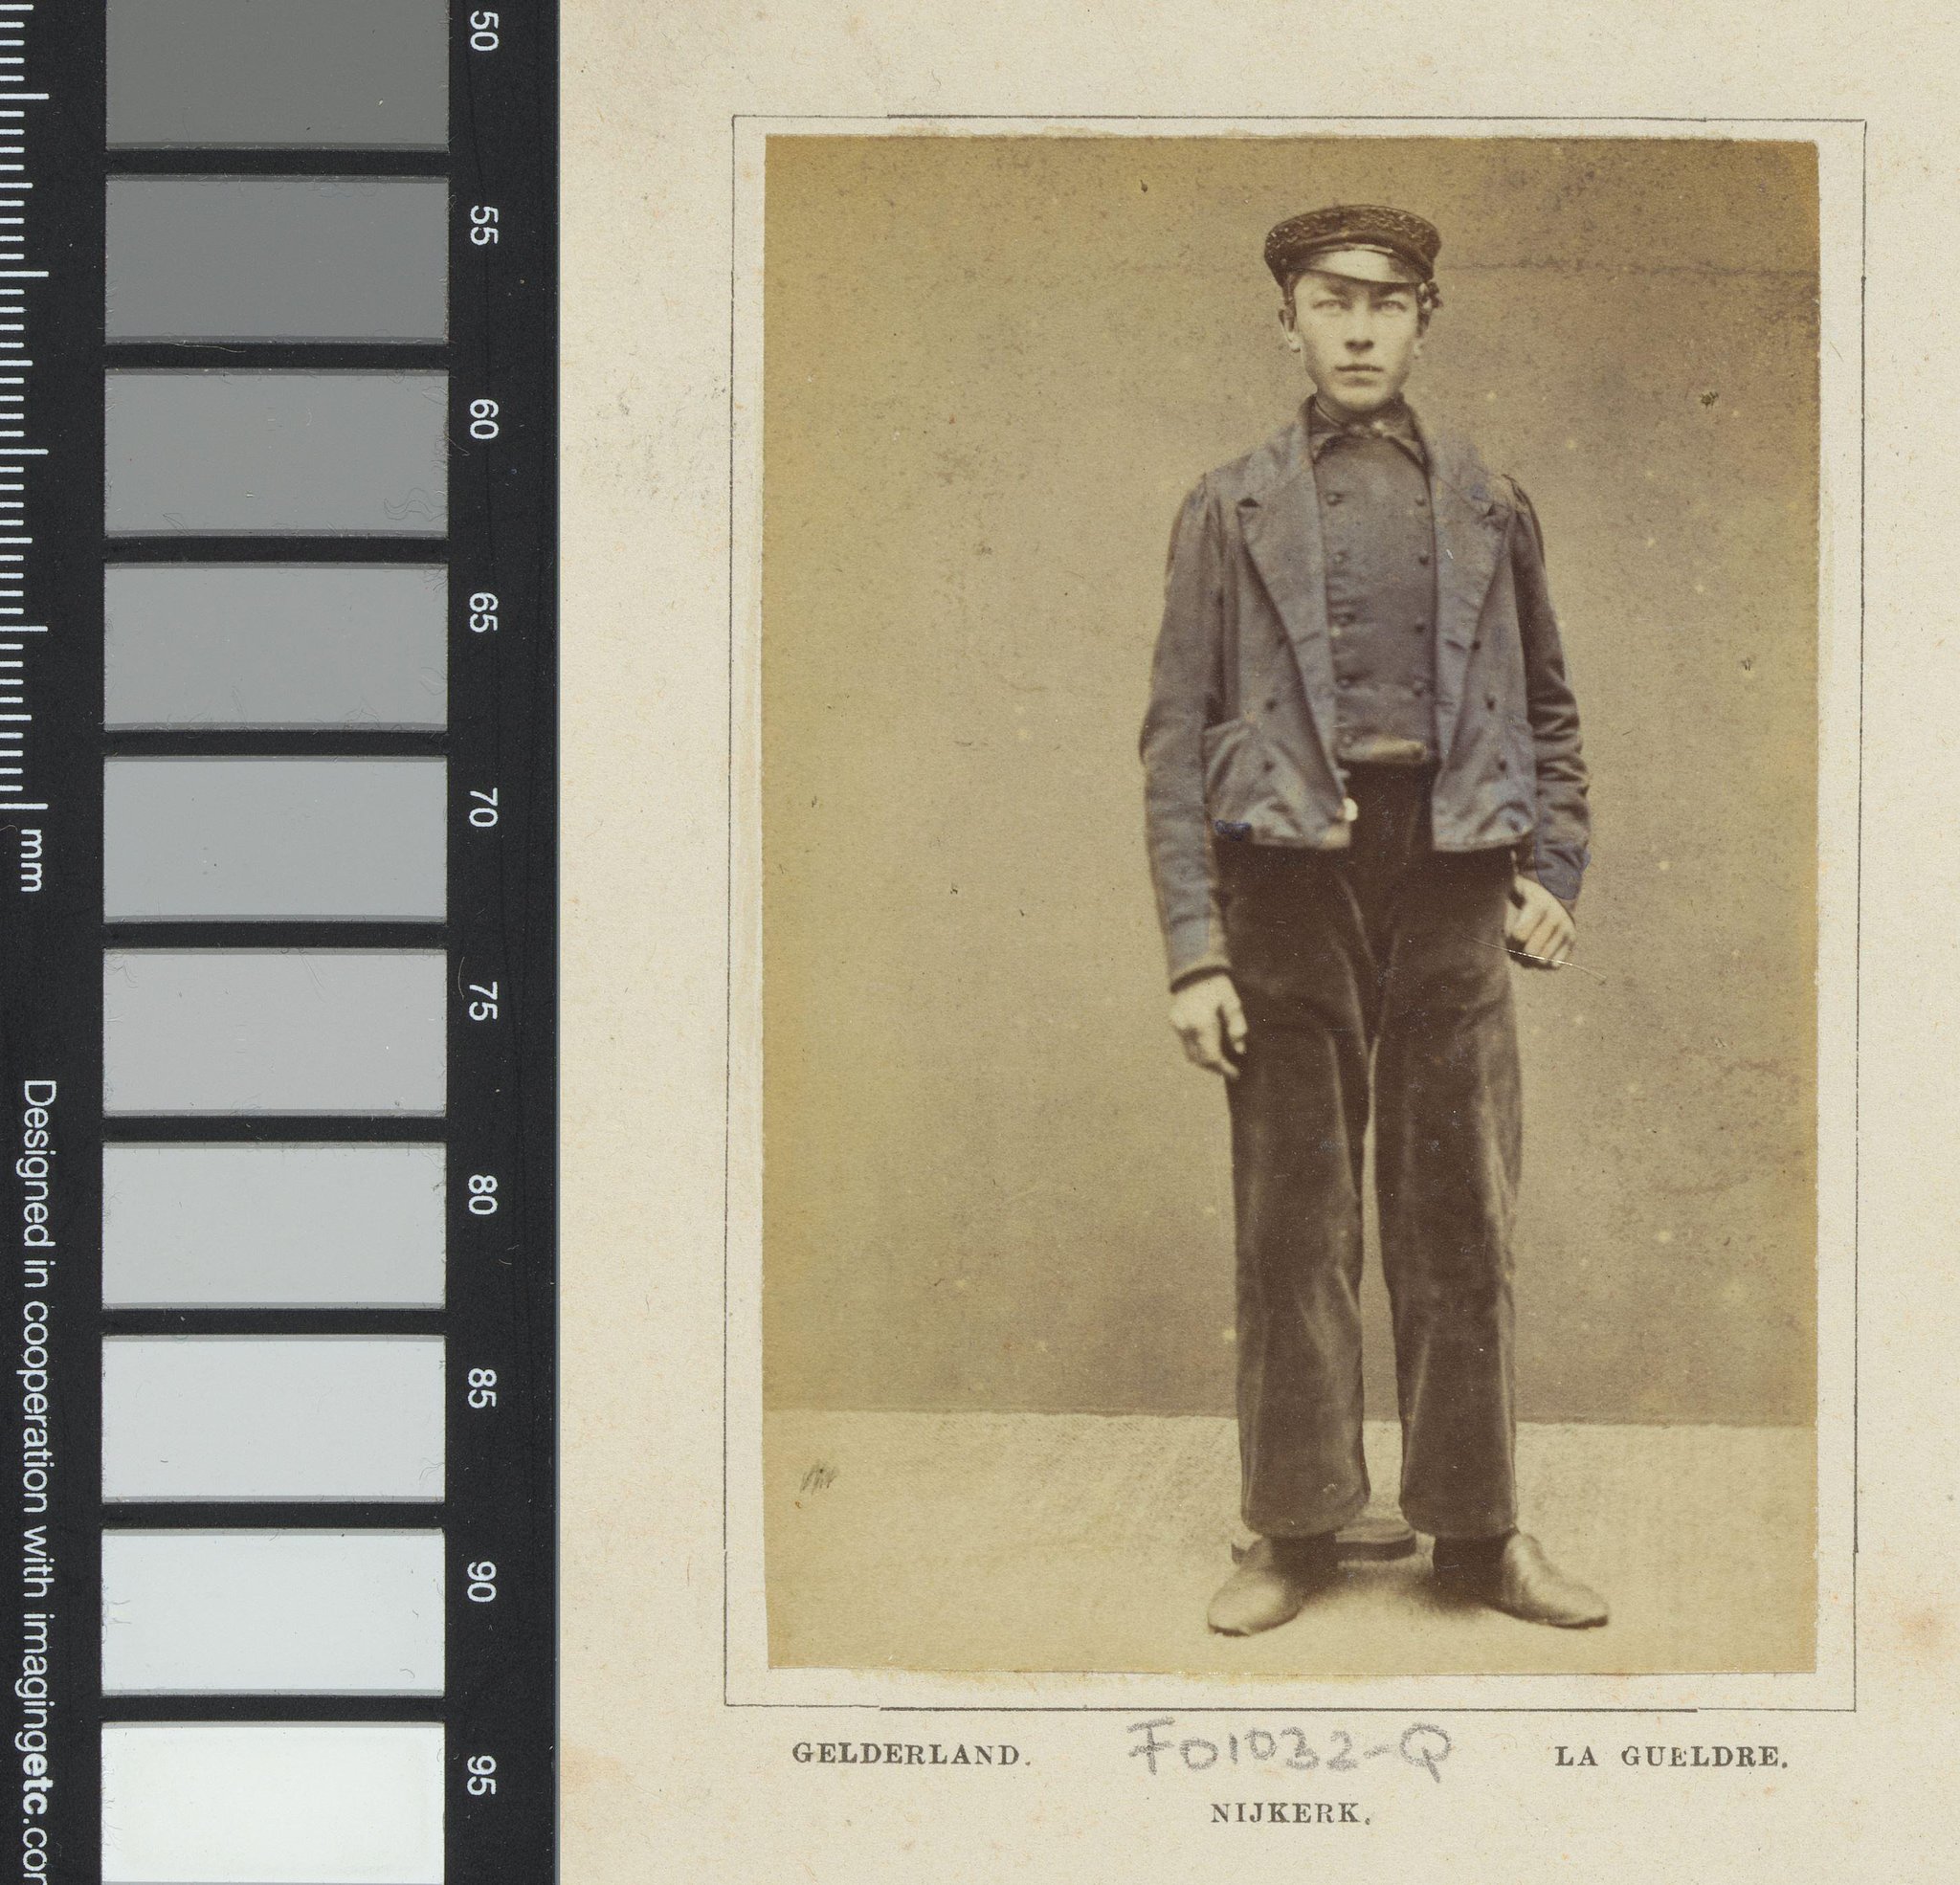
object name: photograph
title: Nederlandsche Kleederdragten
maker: andries jager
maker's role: publisher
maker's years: 1825-1905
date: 1860-1890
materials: cardboard, photographic support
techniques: albumen print, hand coloring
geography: amsterdam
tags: folk costume, regional costume (+ men's clothes), historical persons, europeans (with name), netherlands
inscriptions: inscription: ‘Uitgave van A. JAGER, Water 110 te Amsterdam.’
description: Deze foto maakt deel uit van een omslag met 48 foto's op 12 bladen.